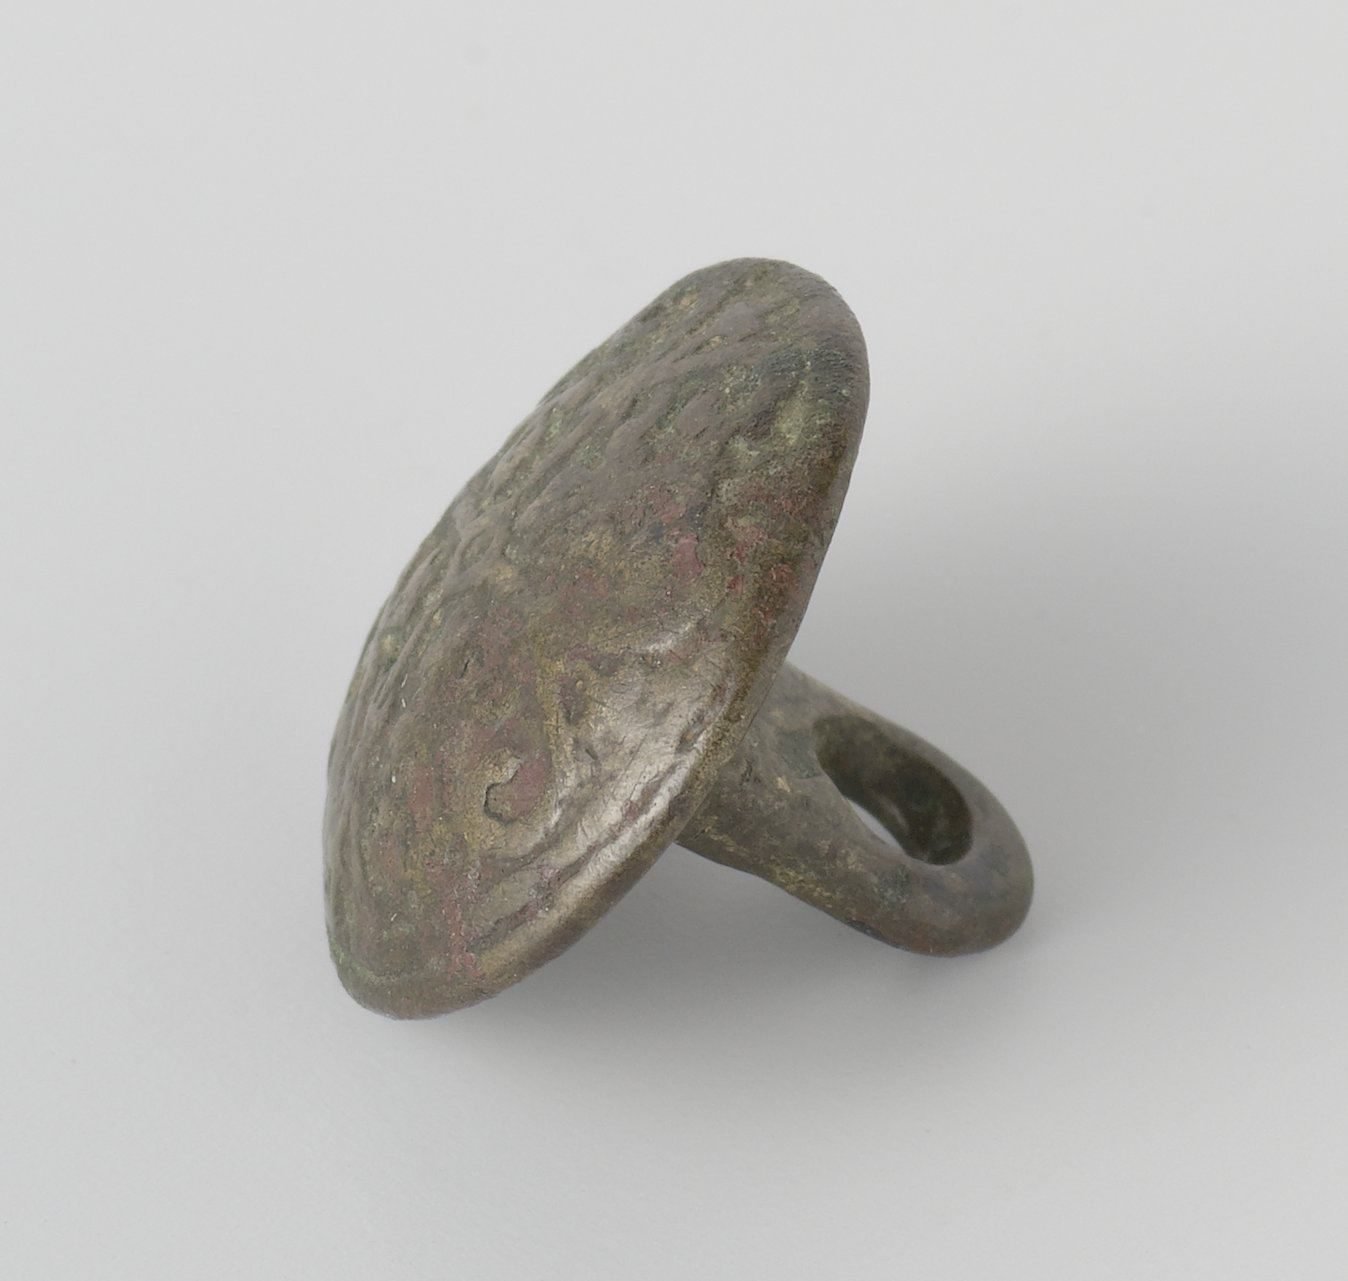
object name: button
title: Knoop van geelkoper met vier lelies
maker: Anonymous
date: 1590-1596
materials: brass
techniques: casting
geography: amsterdam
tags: willem barendsz., amsterdam, jacob van heemskerck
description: Knoop van geelkoper met vier lelies ter decoratie. De knopen NG-NM-7723-7, NG-NM-7723-8 en NG-NM-7723-10 zijn niet identiek.